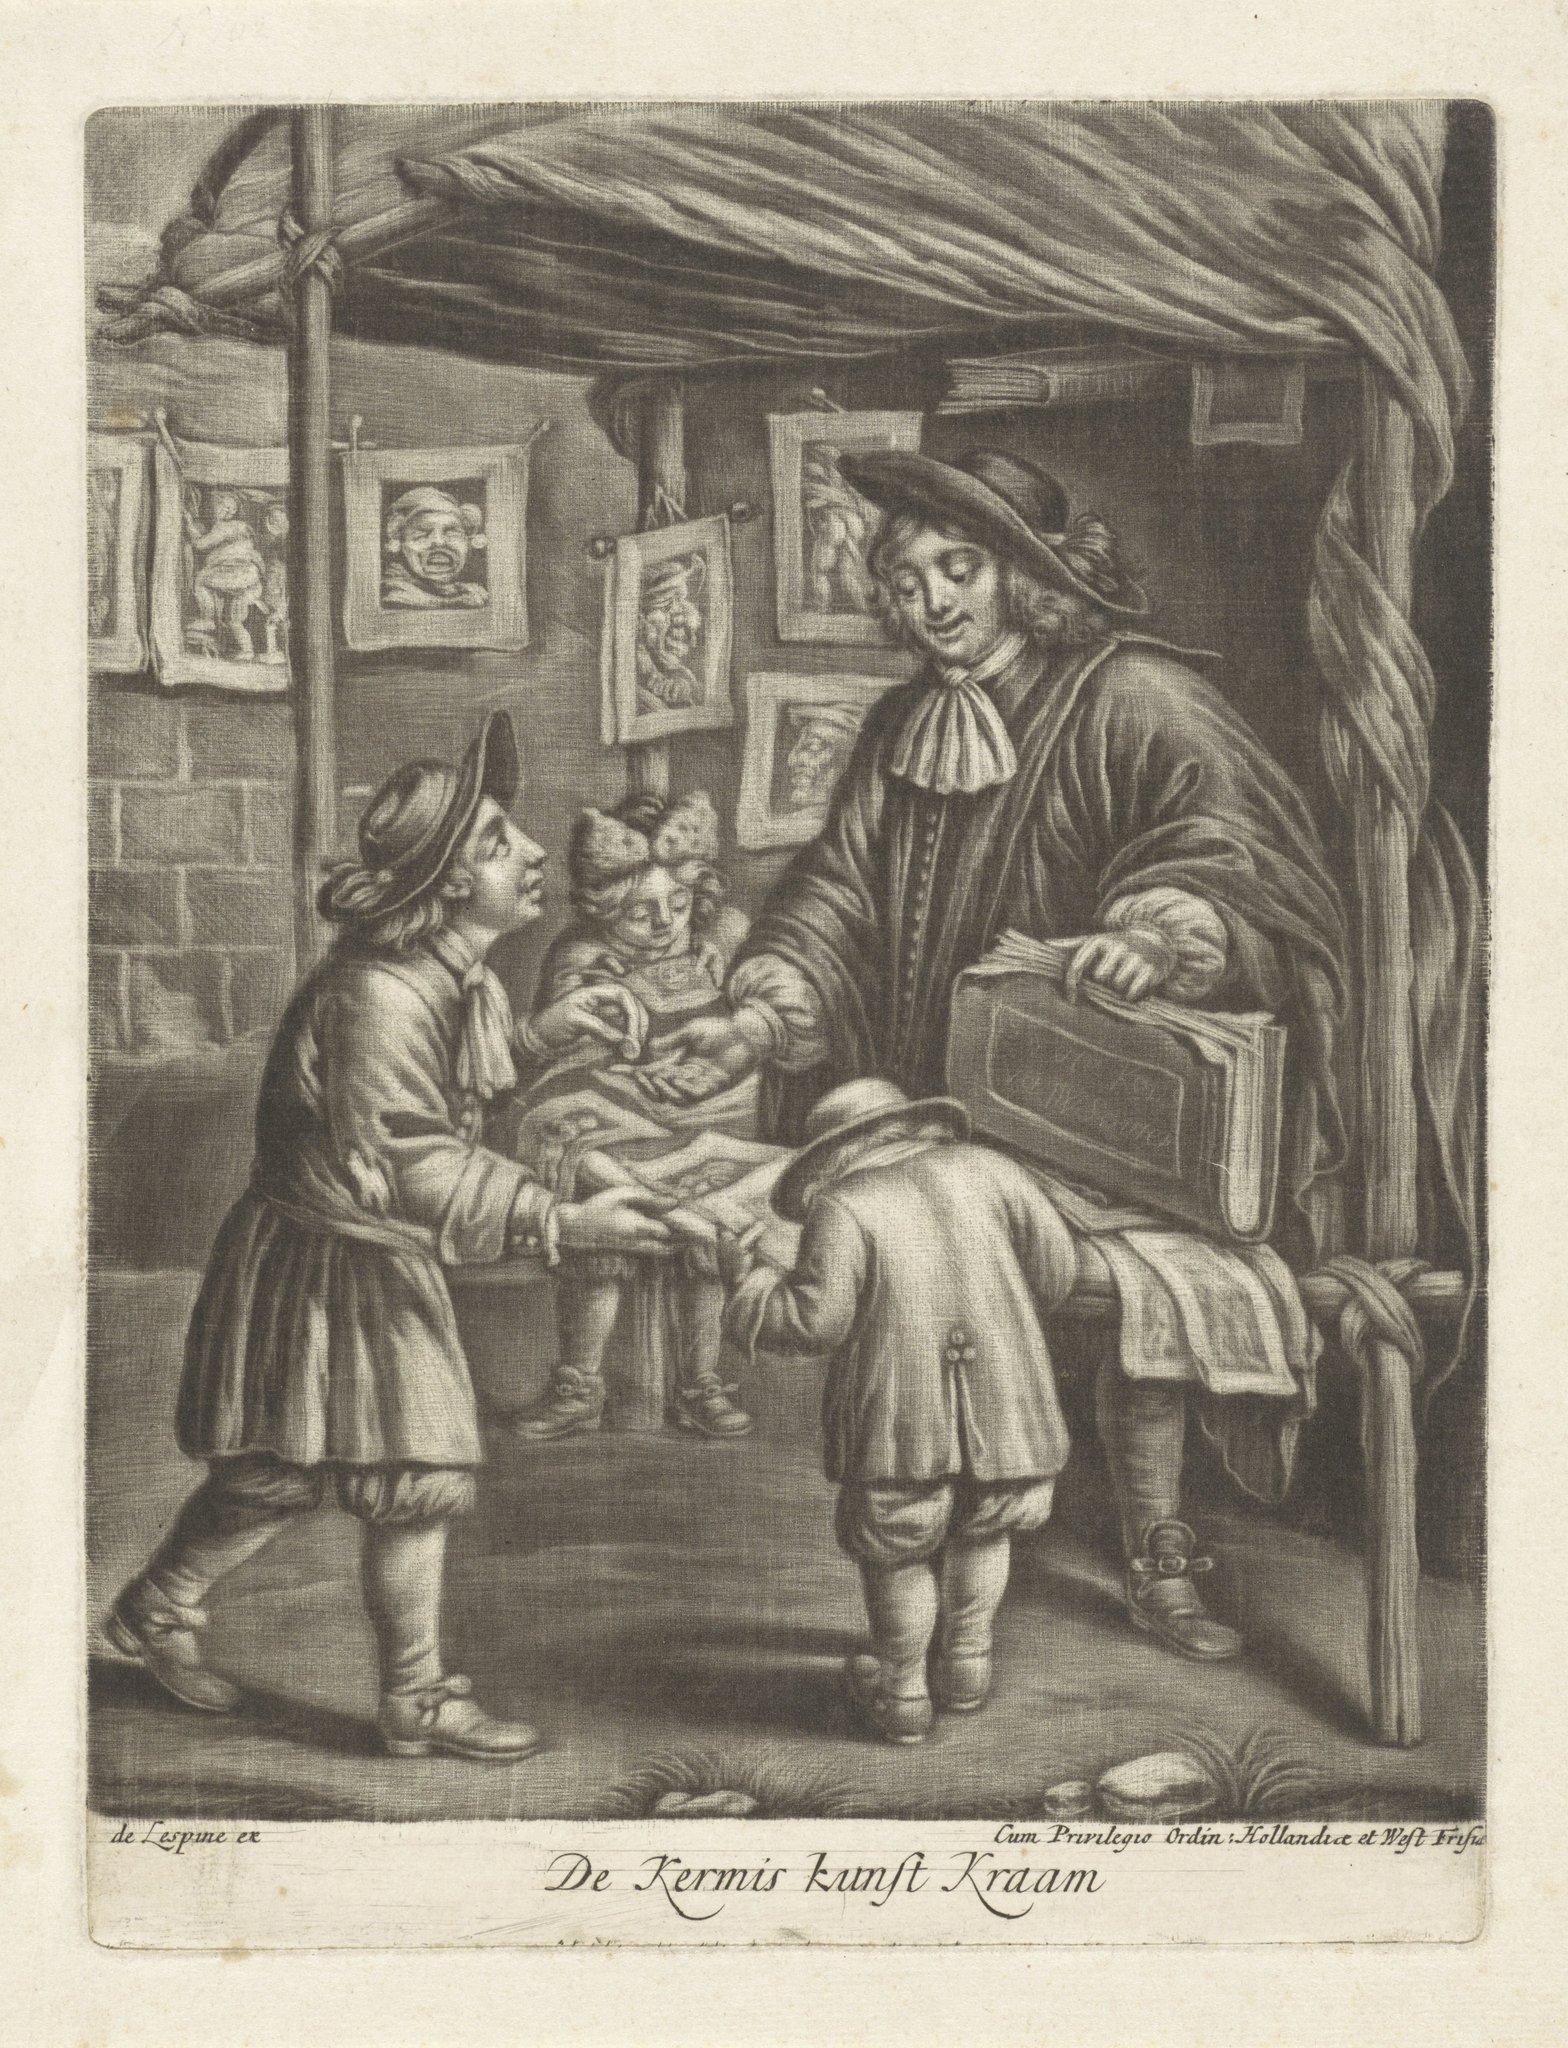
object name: print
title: Prentverkoper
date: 1655-1700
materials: paper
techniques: mezzotint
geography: amsterdam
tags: print, e.g.: engraving, etching, lithograph, street-trader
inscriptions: collector's mark: Lugt 2228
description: Een prentverkoper verkoopt een prent aan een van de drie kinderen die bij zijn kraam staan. In zijn kraam liggen prenten uitgestald, en ook aan de muren daar omheen hangt drukwerk. Op een van de prenten is te zien hoe een vrouw met een eigen wind een kaars dooft.